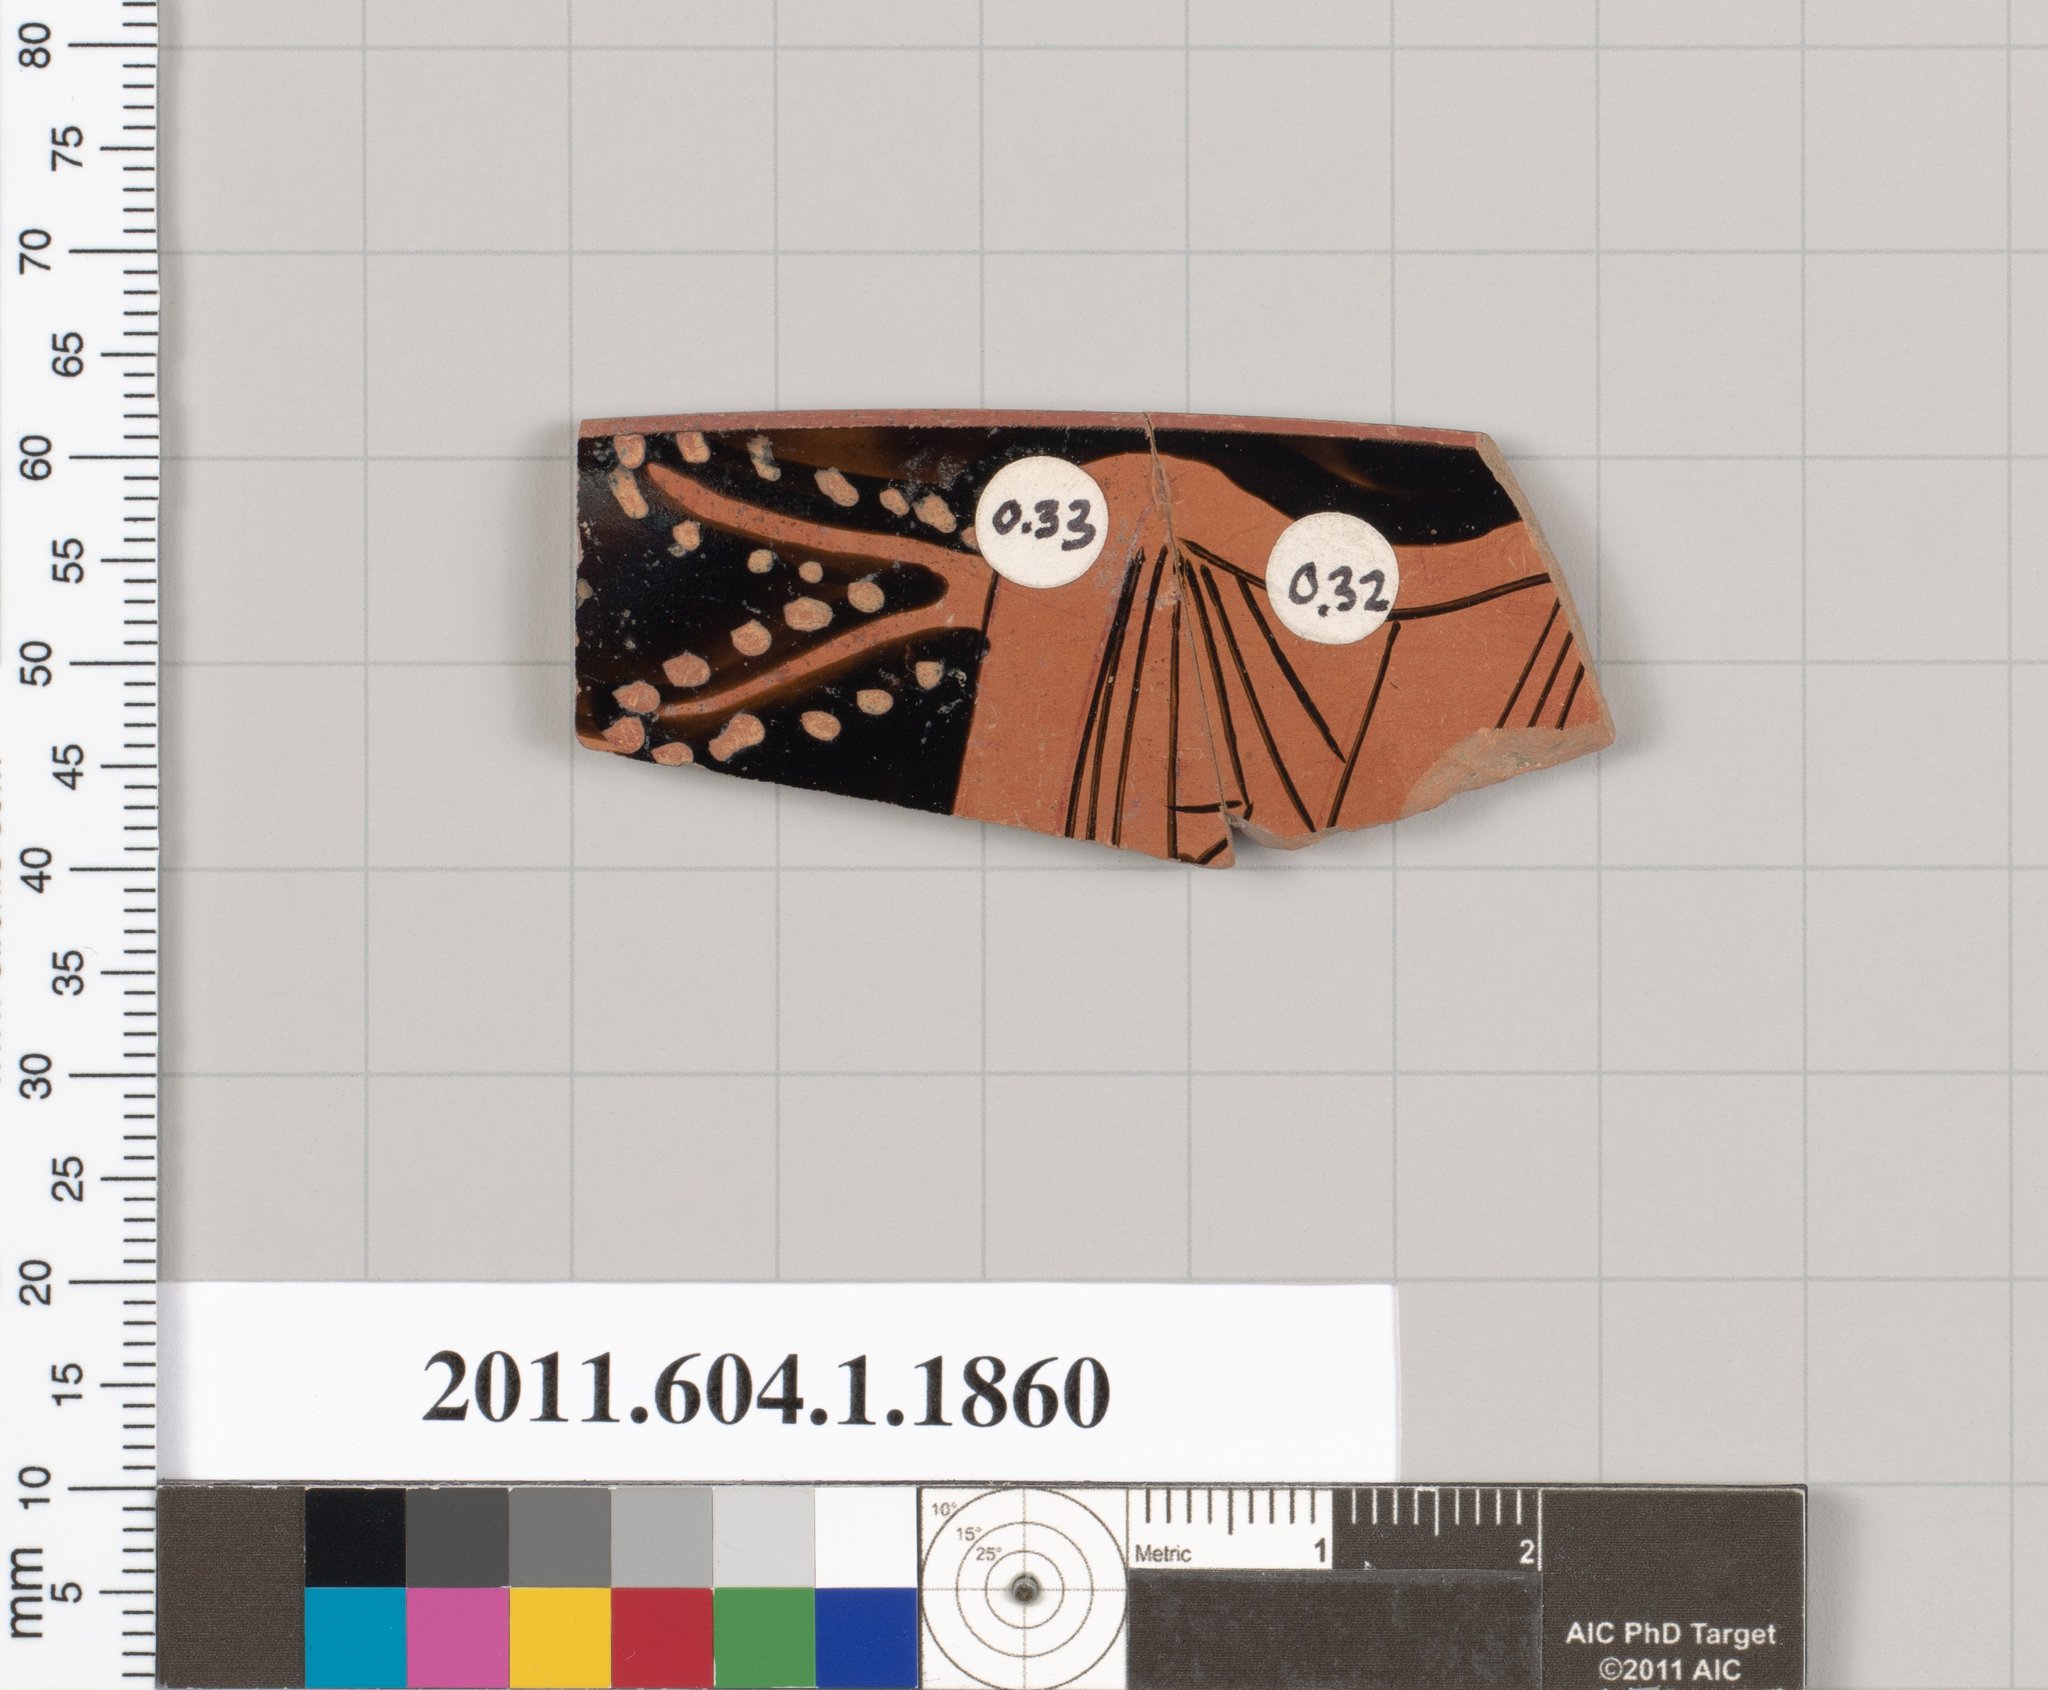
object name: kylix fragment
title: Terracotta rim fragment of a kylix (drinking cup)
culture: greek, attic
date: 534-501 BCE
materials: terracotta